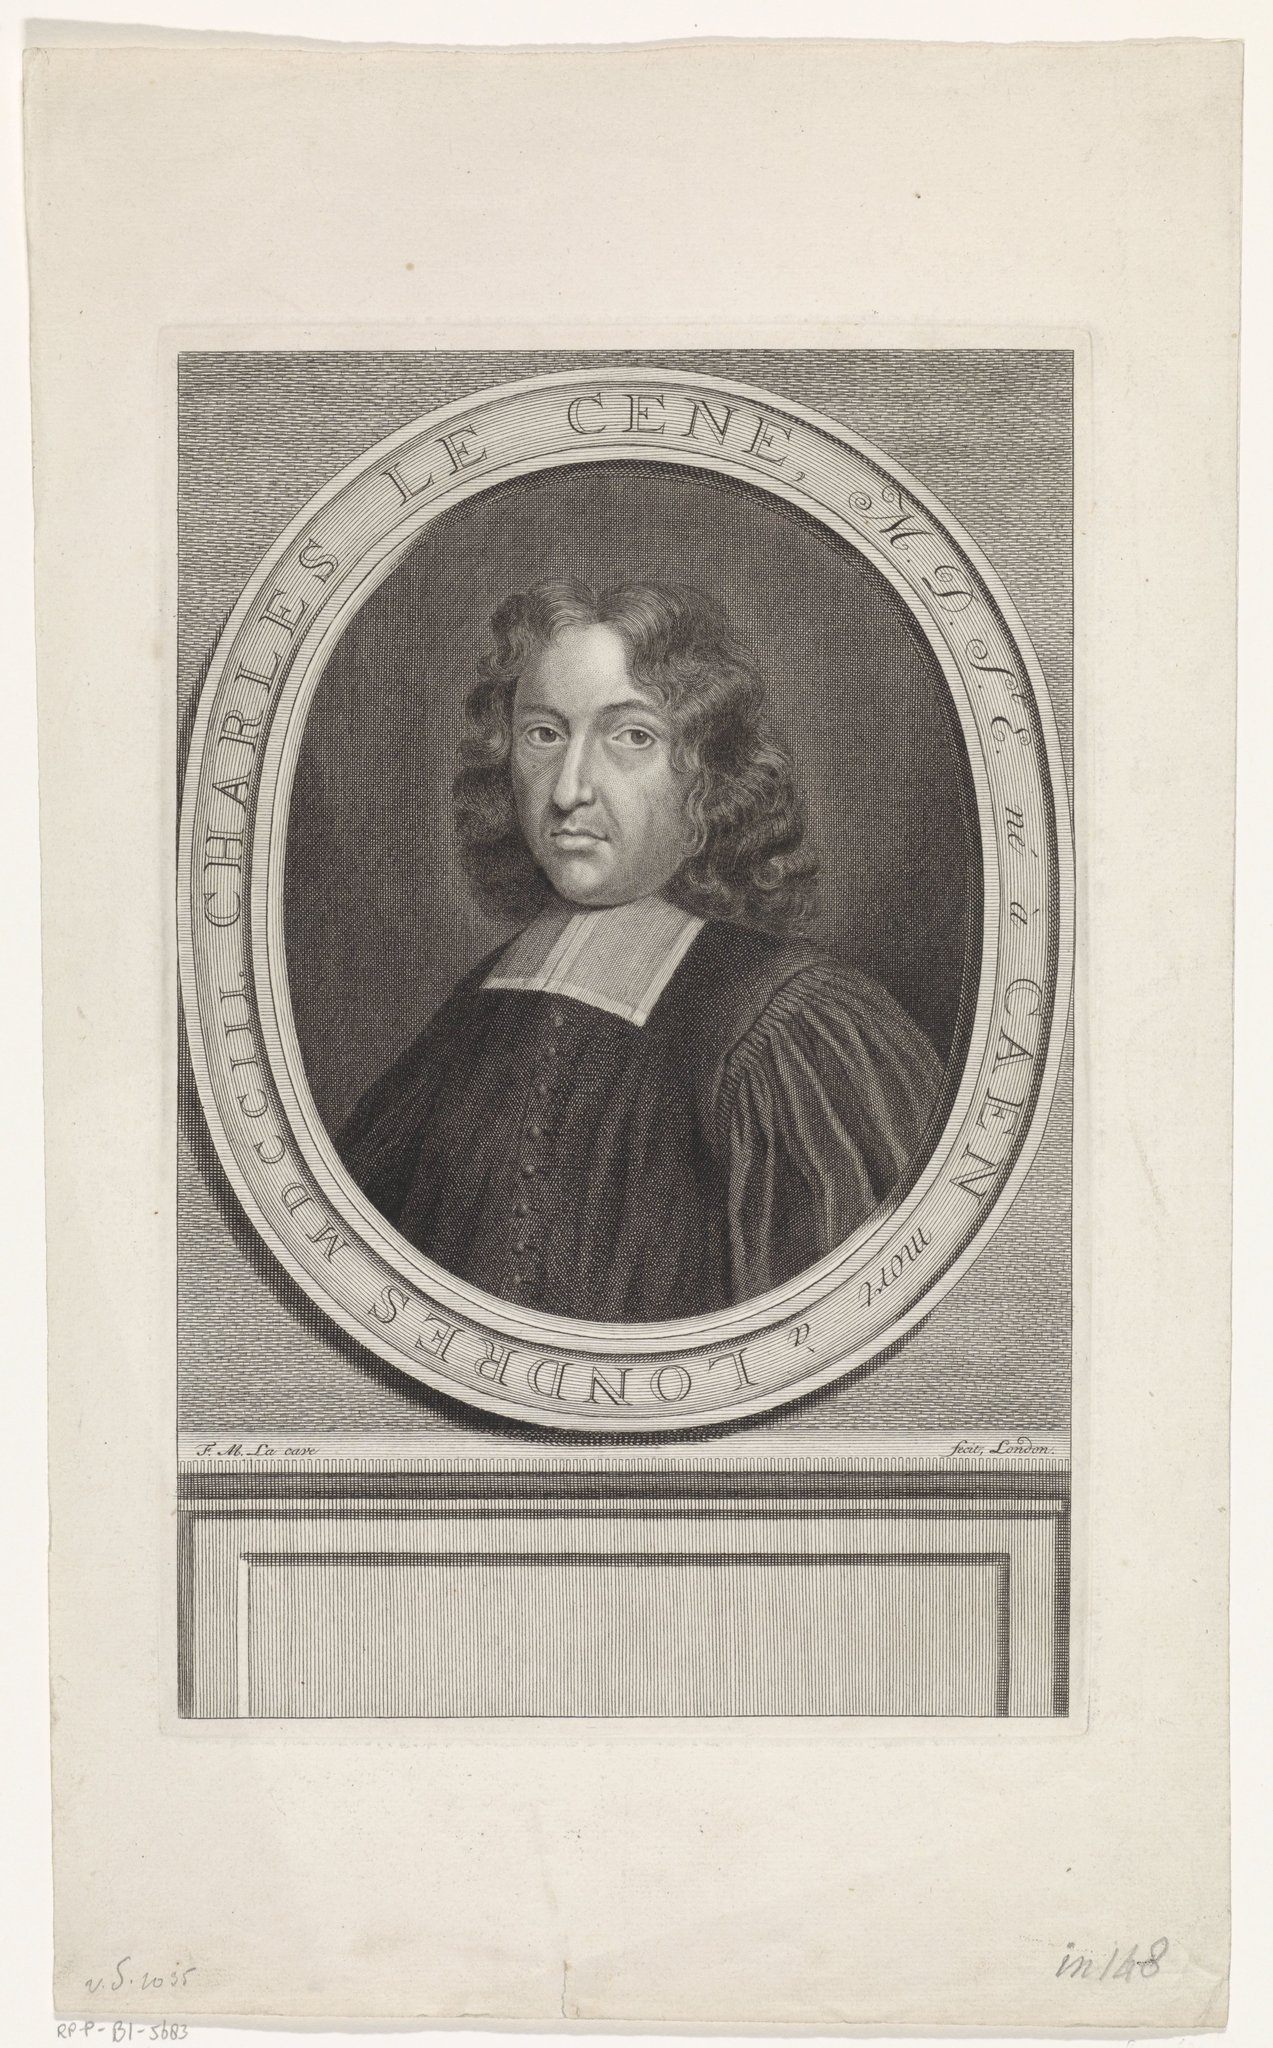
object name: print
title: Portret van Charles le Cene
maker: françois morellon la cave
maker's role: draughtsman, print maker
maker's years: 1696-1768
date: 1731-1734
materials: paper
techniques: engraving, etching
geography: london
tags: london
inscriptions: collector's mark: Lugt 2228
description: Portret van predikant Charles le Cene. Hij maakte een Bijbelvertaling in het Frans.